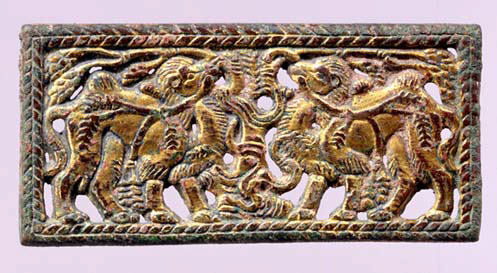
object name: belt buckle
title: Belt Buckle with Bactrian Camels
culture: north chinese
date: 200-101 BCE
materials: bronze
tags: camels